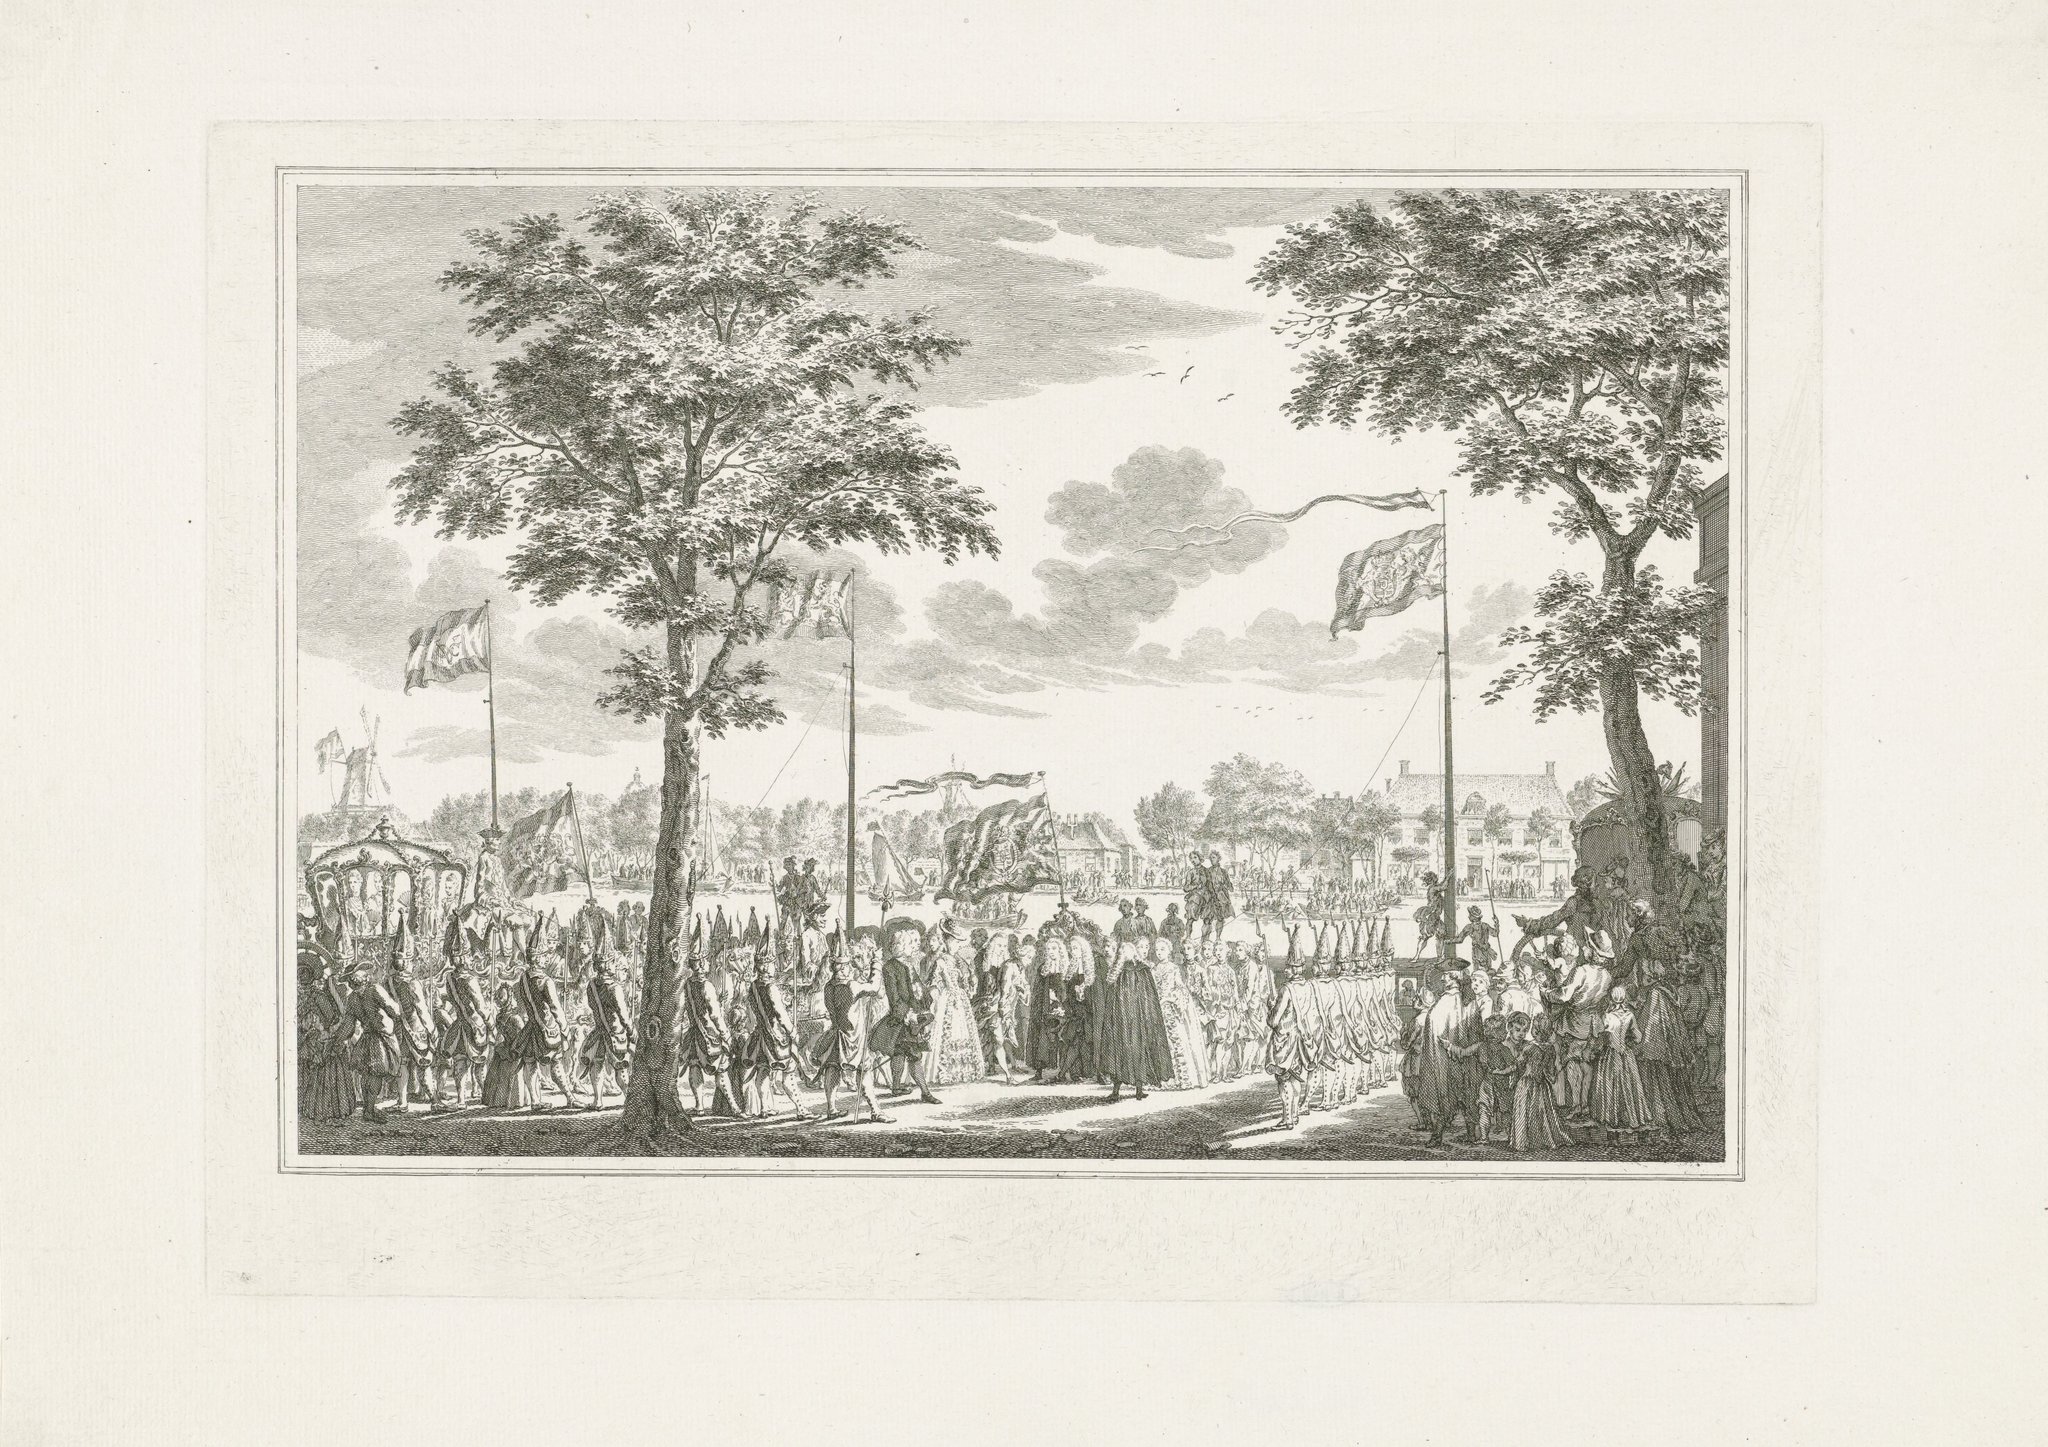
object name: print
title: Afbeelding der Vreugdebedryven en Plegtigheden die by de aankomst en gedurende het verblyf (...) Willem (...) en zyne Gemaalinne (...) zyn voorgevallen te Amsterdam, op maandag, den 30 Mey, en eenige volgende dagen, des jaars 1768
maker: simon fokke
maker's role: draughtsman, print maker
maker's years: 1712-1784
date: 1769-1773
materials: paper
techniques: etching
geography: northern netherlands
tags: the hague, william v (prince of orange), berlin, painter, draughtsman, wilhelmina of prussia (princess of orange), public festivities on the occasion of royal events, amsterdam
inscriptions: collector's mark: Lugt 2228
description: De stadhouder Willem V en prinses Wilhelmina van Pruisen nemen afscheid van het magistraat van Amsterdam bij de herberg De Berebijt aan de Buitenamstel, 4 juni 1768. Onderdeel van een prentserie met titelprent en 14 platen van de inhaling van de prins en prinses te Amsterdam, 30 mei - 4 juni 1768.